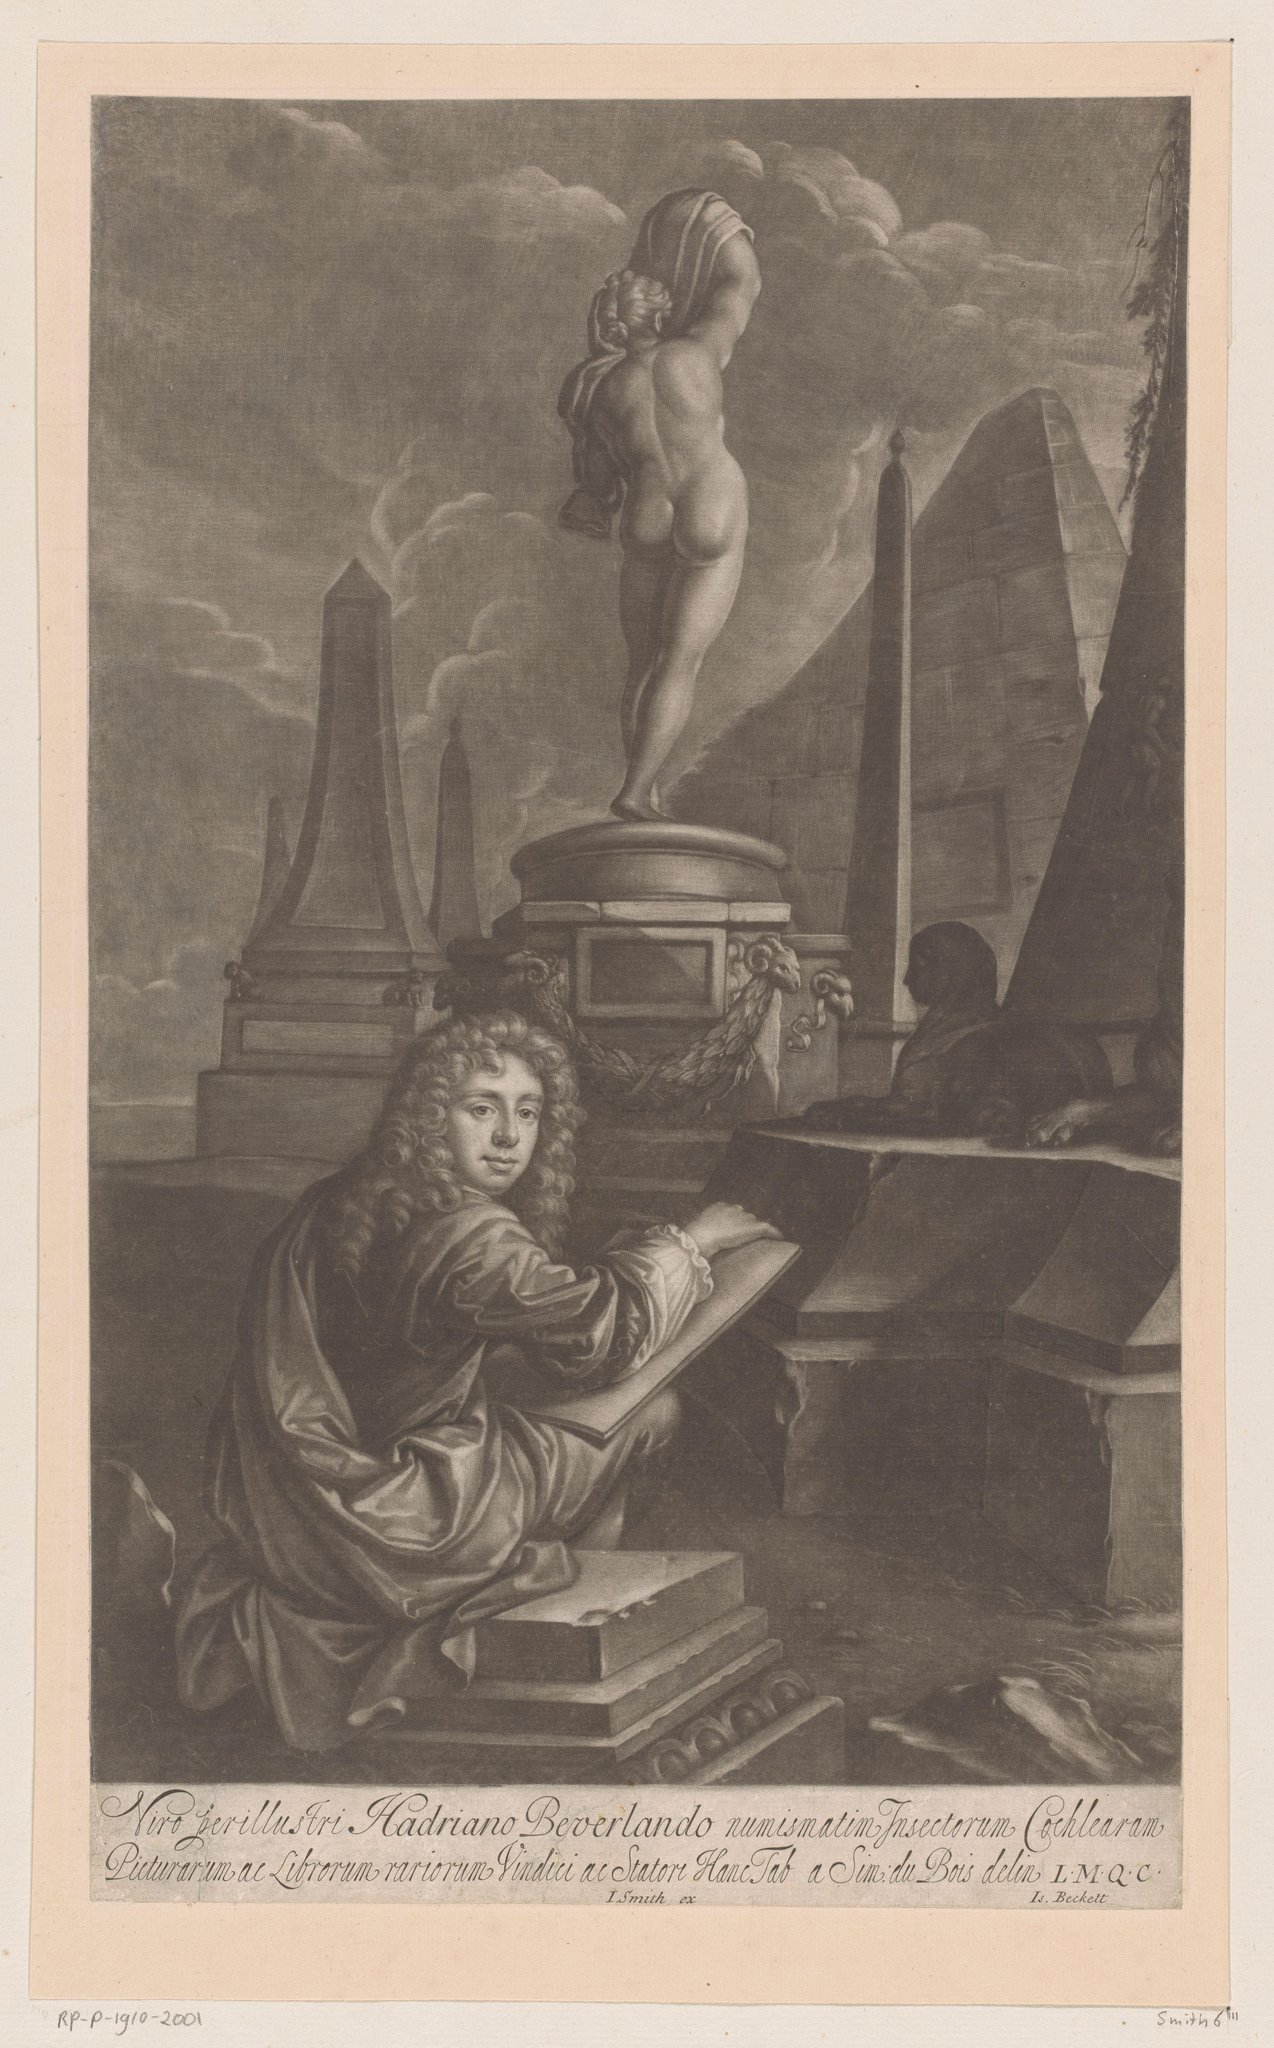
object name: print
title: Portrait of Hadriaan Beverland Drawing a Statue of Venus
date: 1686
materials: paper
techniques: mezzotint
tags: middelburg, historical persons, draughtsman studying classical remains - cc - out of doors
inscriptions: collector's mark: Lugt 2228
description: In London, Beverland made a living as an art and book agent. He tracked down interesting antiquities, shells and manuscripts for wealthy collectors. Here he is surrounded by Egyptian monuments and a sensuous statue of Venus, the goddess of love. Naughtily positioned, with a view of Venus’ bare buttocks, Beverland draws the statue. The inscription boasts of his expert knowledge.